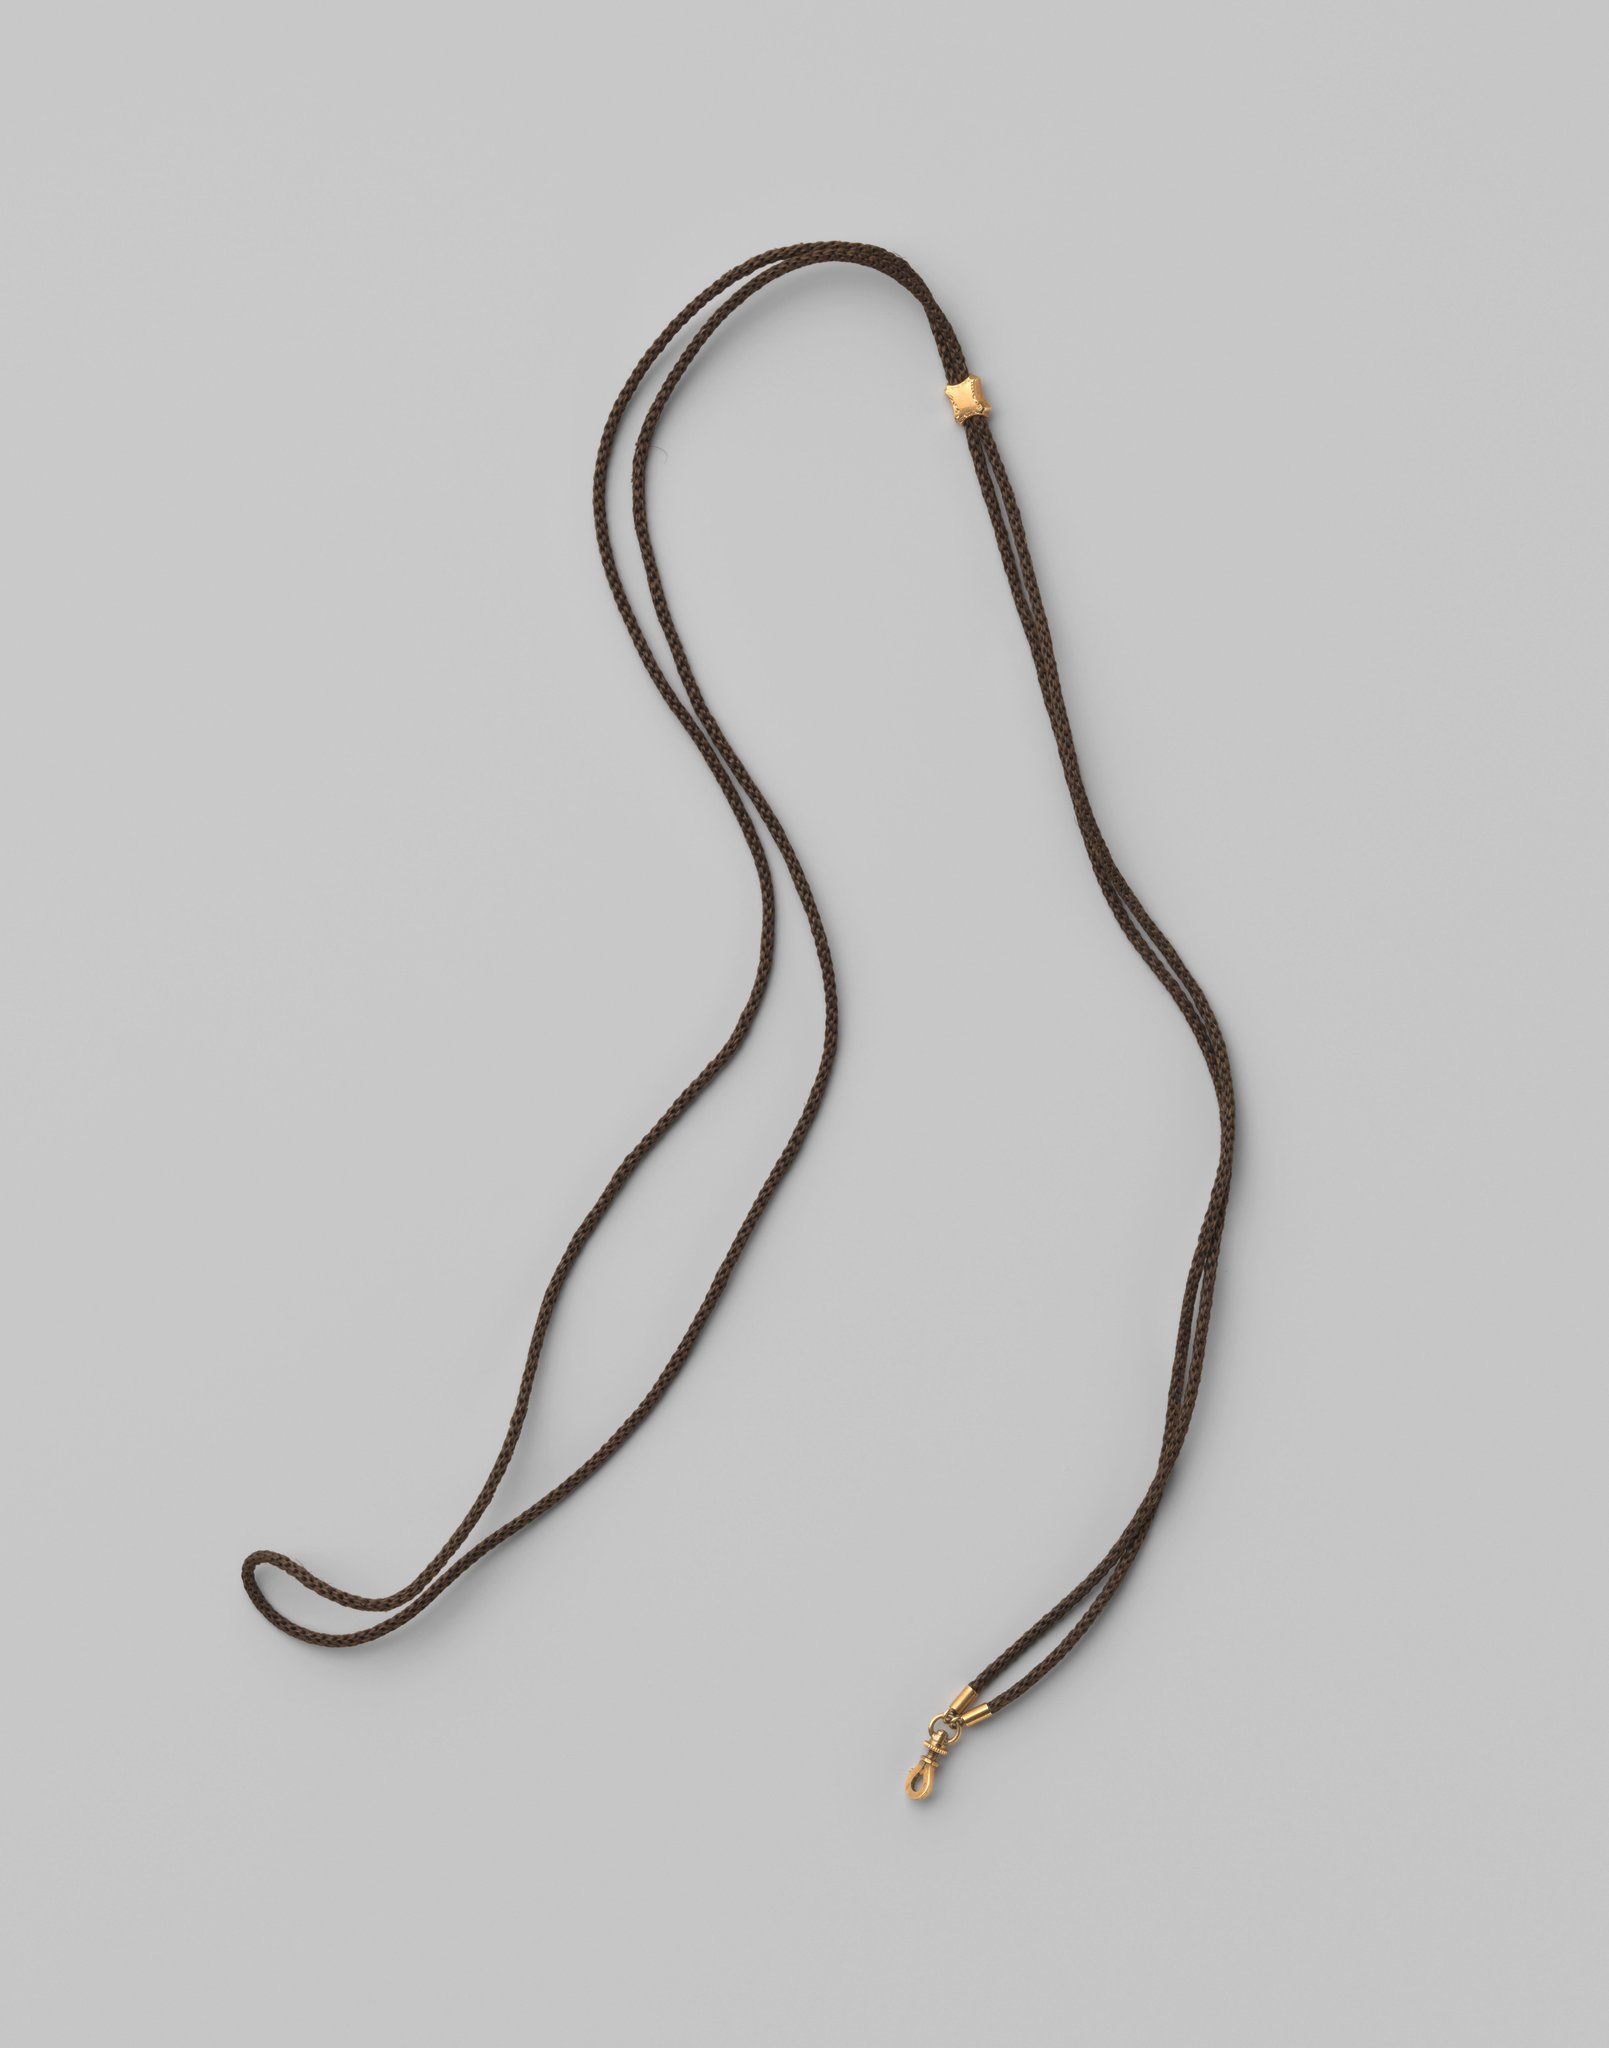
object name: jewellery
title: Horlogeketting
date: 1840-1845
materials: gold, hair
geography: amsterdam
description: Dames-horlogeketting van een lang en dun gedraaid of geknoopt koord. Het ringetje en de haak zijn driemaal germerkt met een eikeblad. Een haarsieraad.